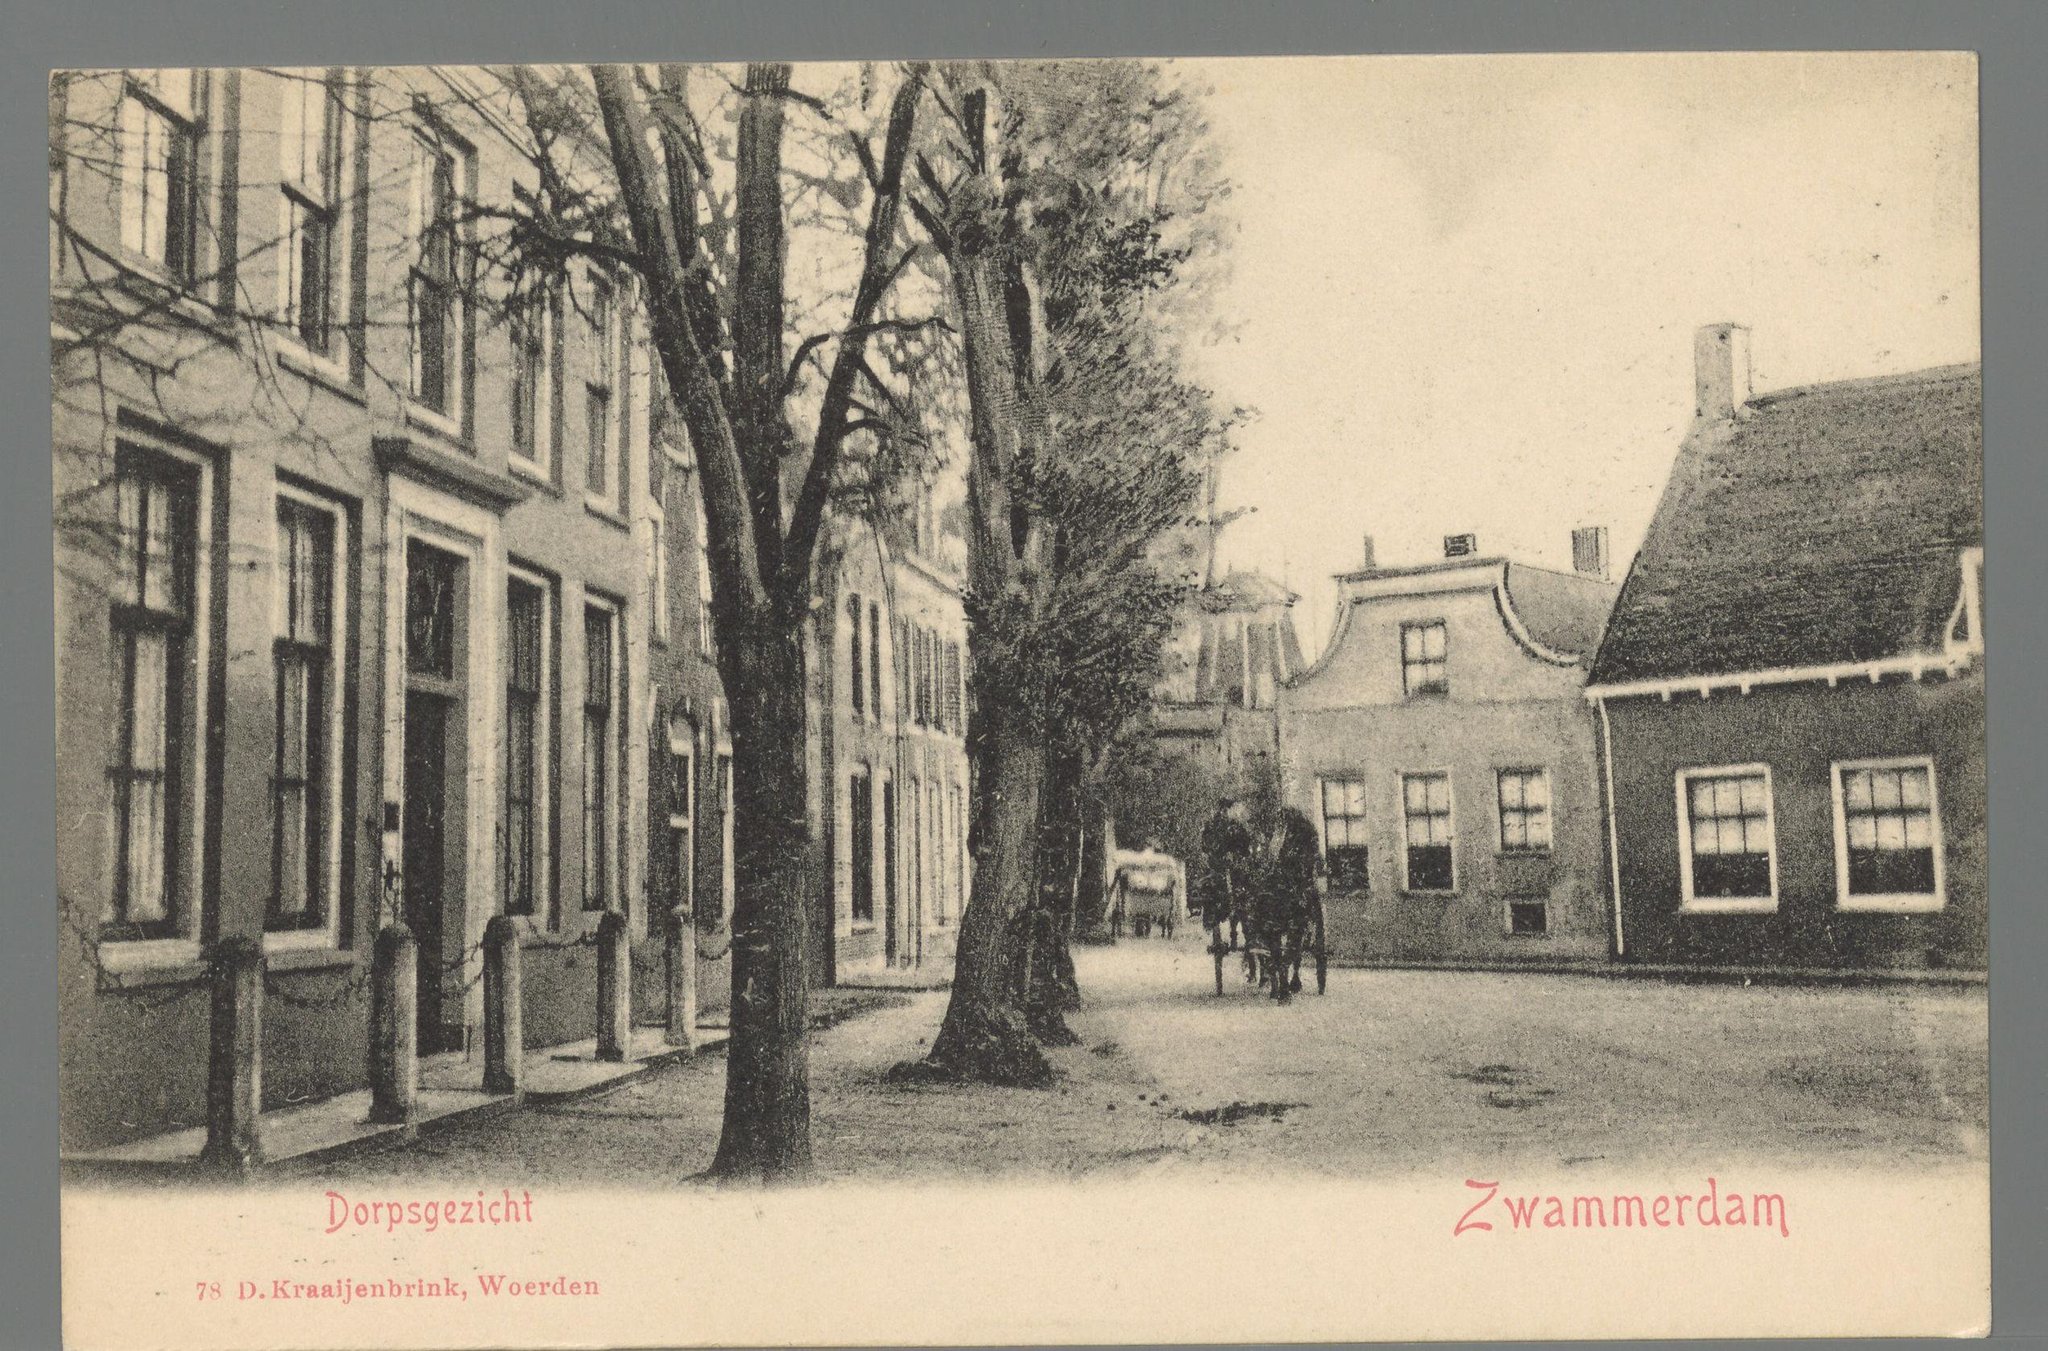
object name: photomechanical print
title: Dorpsgezicht. Zwammerdam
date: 1897-1905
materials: cardboard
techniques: photograph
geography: zwammerdam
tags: street